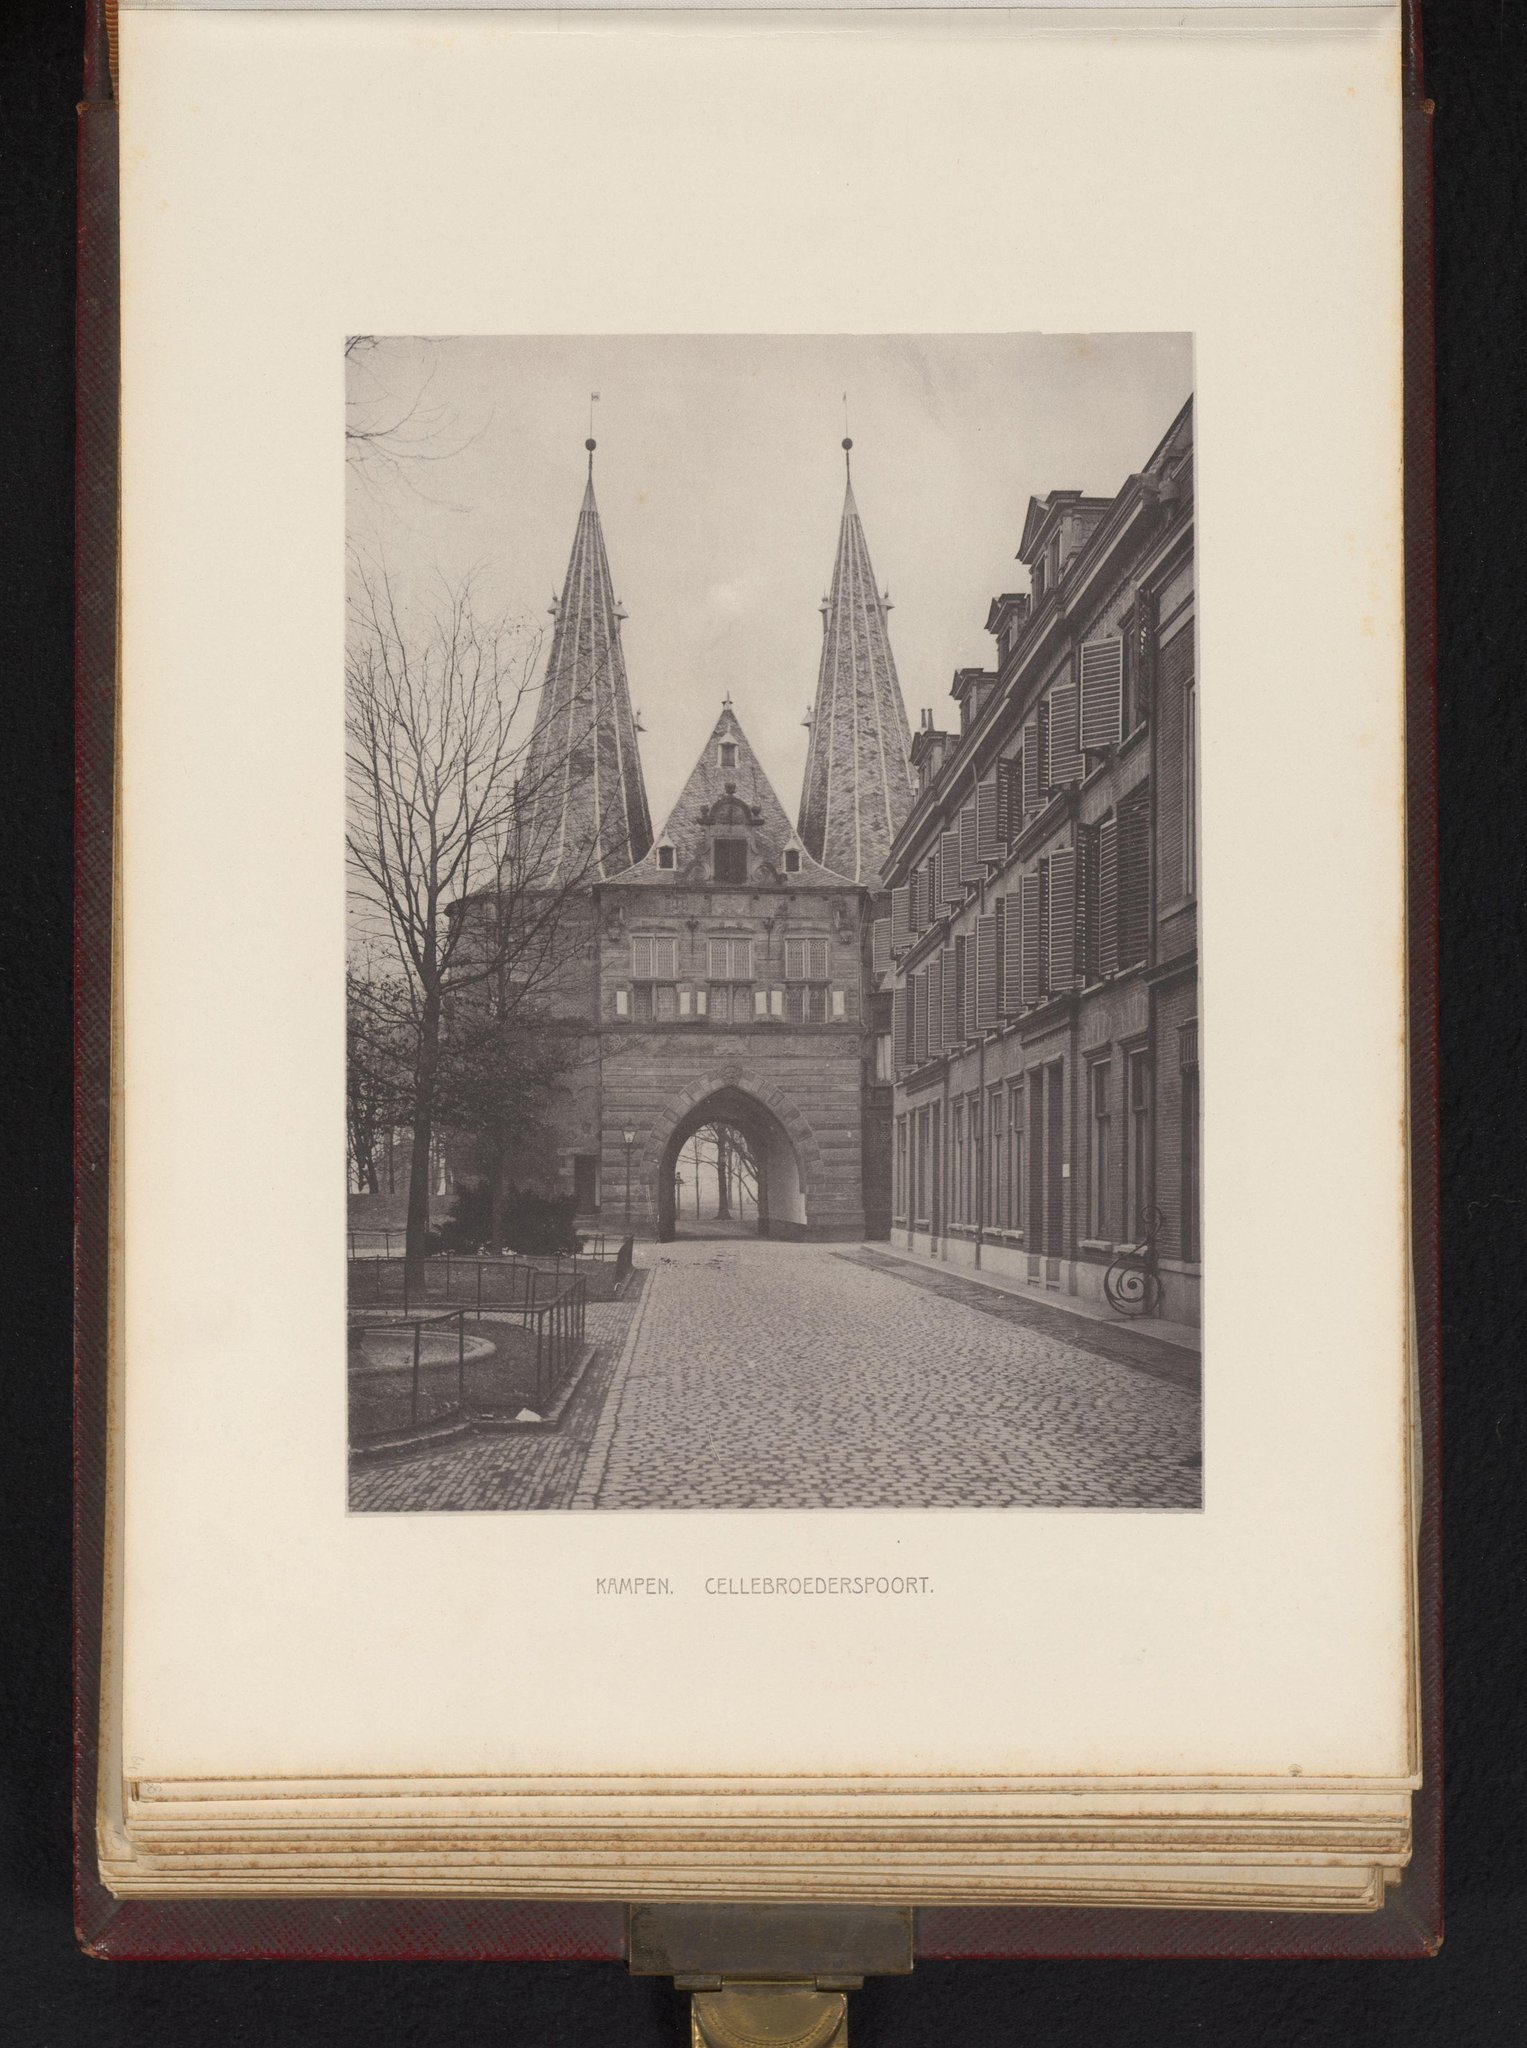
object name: album leaf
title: Kampen Cellebroederspoort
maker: Anonymous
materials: paper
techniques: photograph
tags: gate, entrance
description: Deze pagina maakt deel uit van een album.